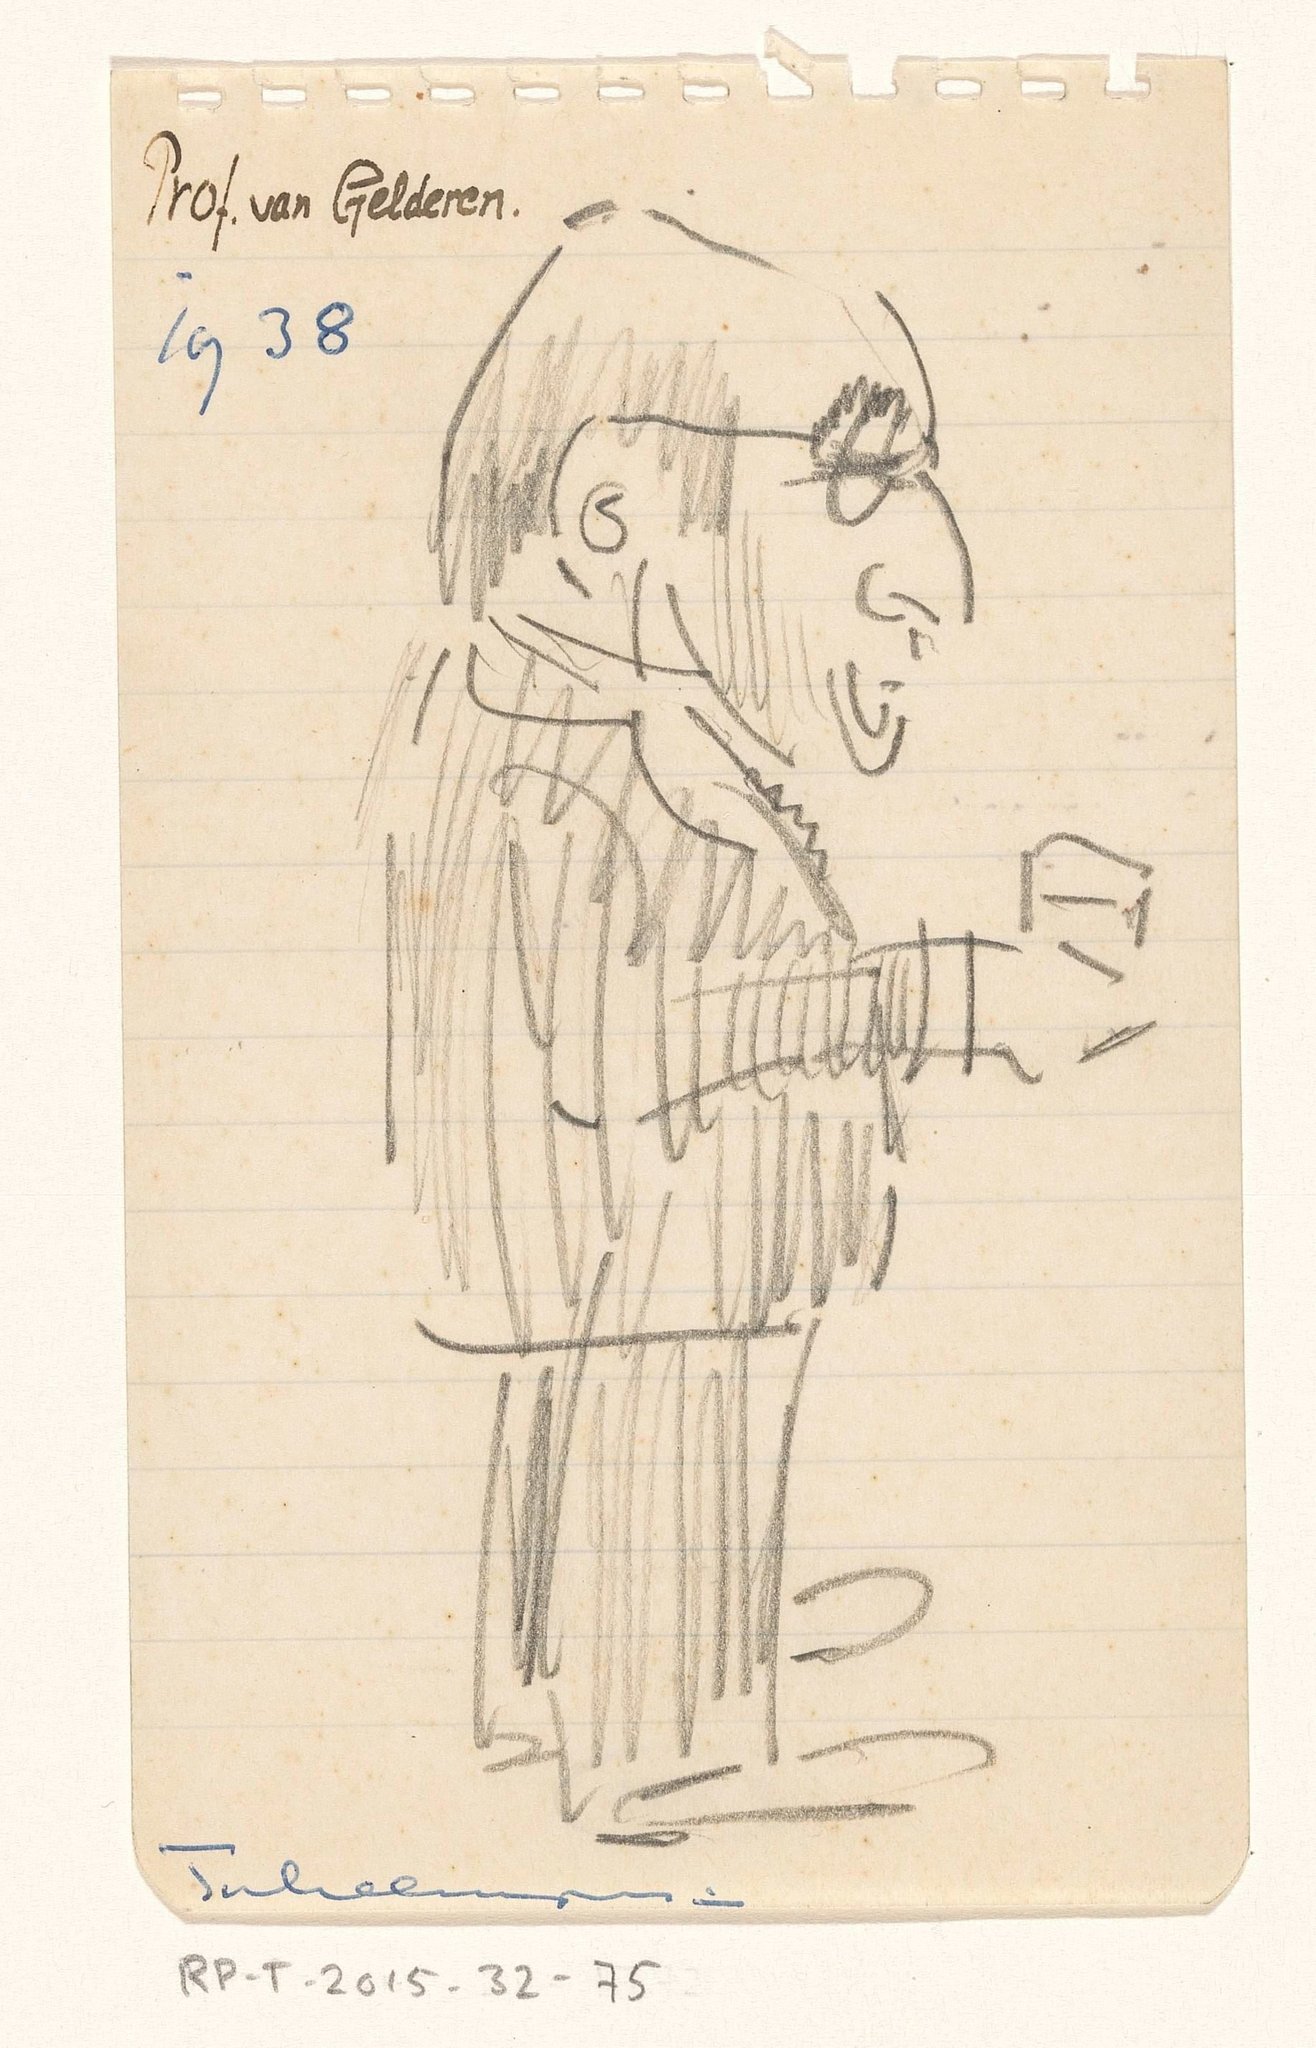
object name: drawing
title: Prof. van Gelderen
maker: Anonymous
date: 1938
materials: ink, pencil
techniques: pen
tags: caricatures (human types), professor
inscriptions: annotation: ‘Prof. van Gelderen’, collector's mark: Lugt 2228, signature: ‘1938 / [onleesbaar signatuur]’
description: Waarschijnlijk een blad uit een notitieblok.